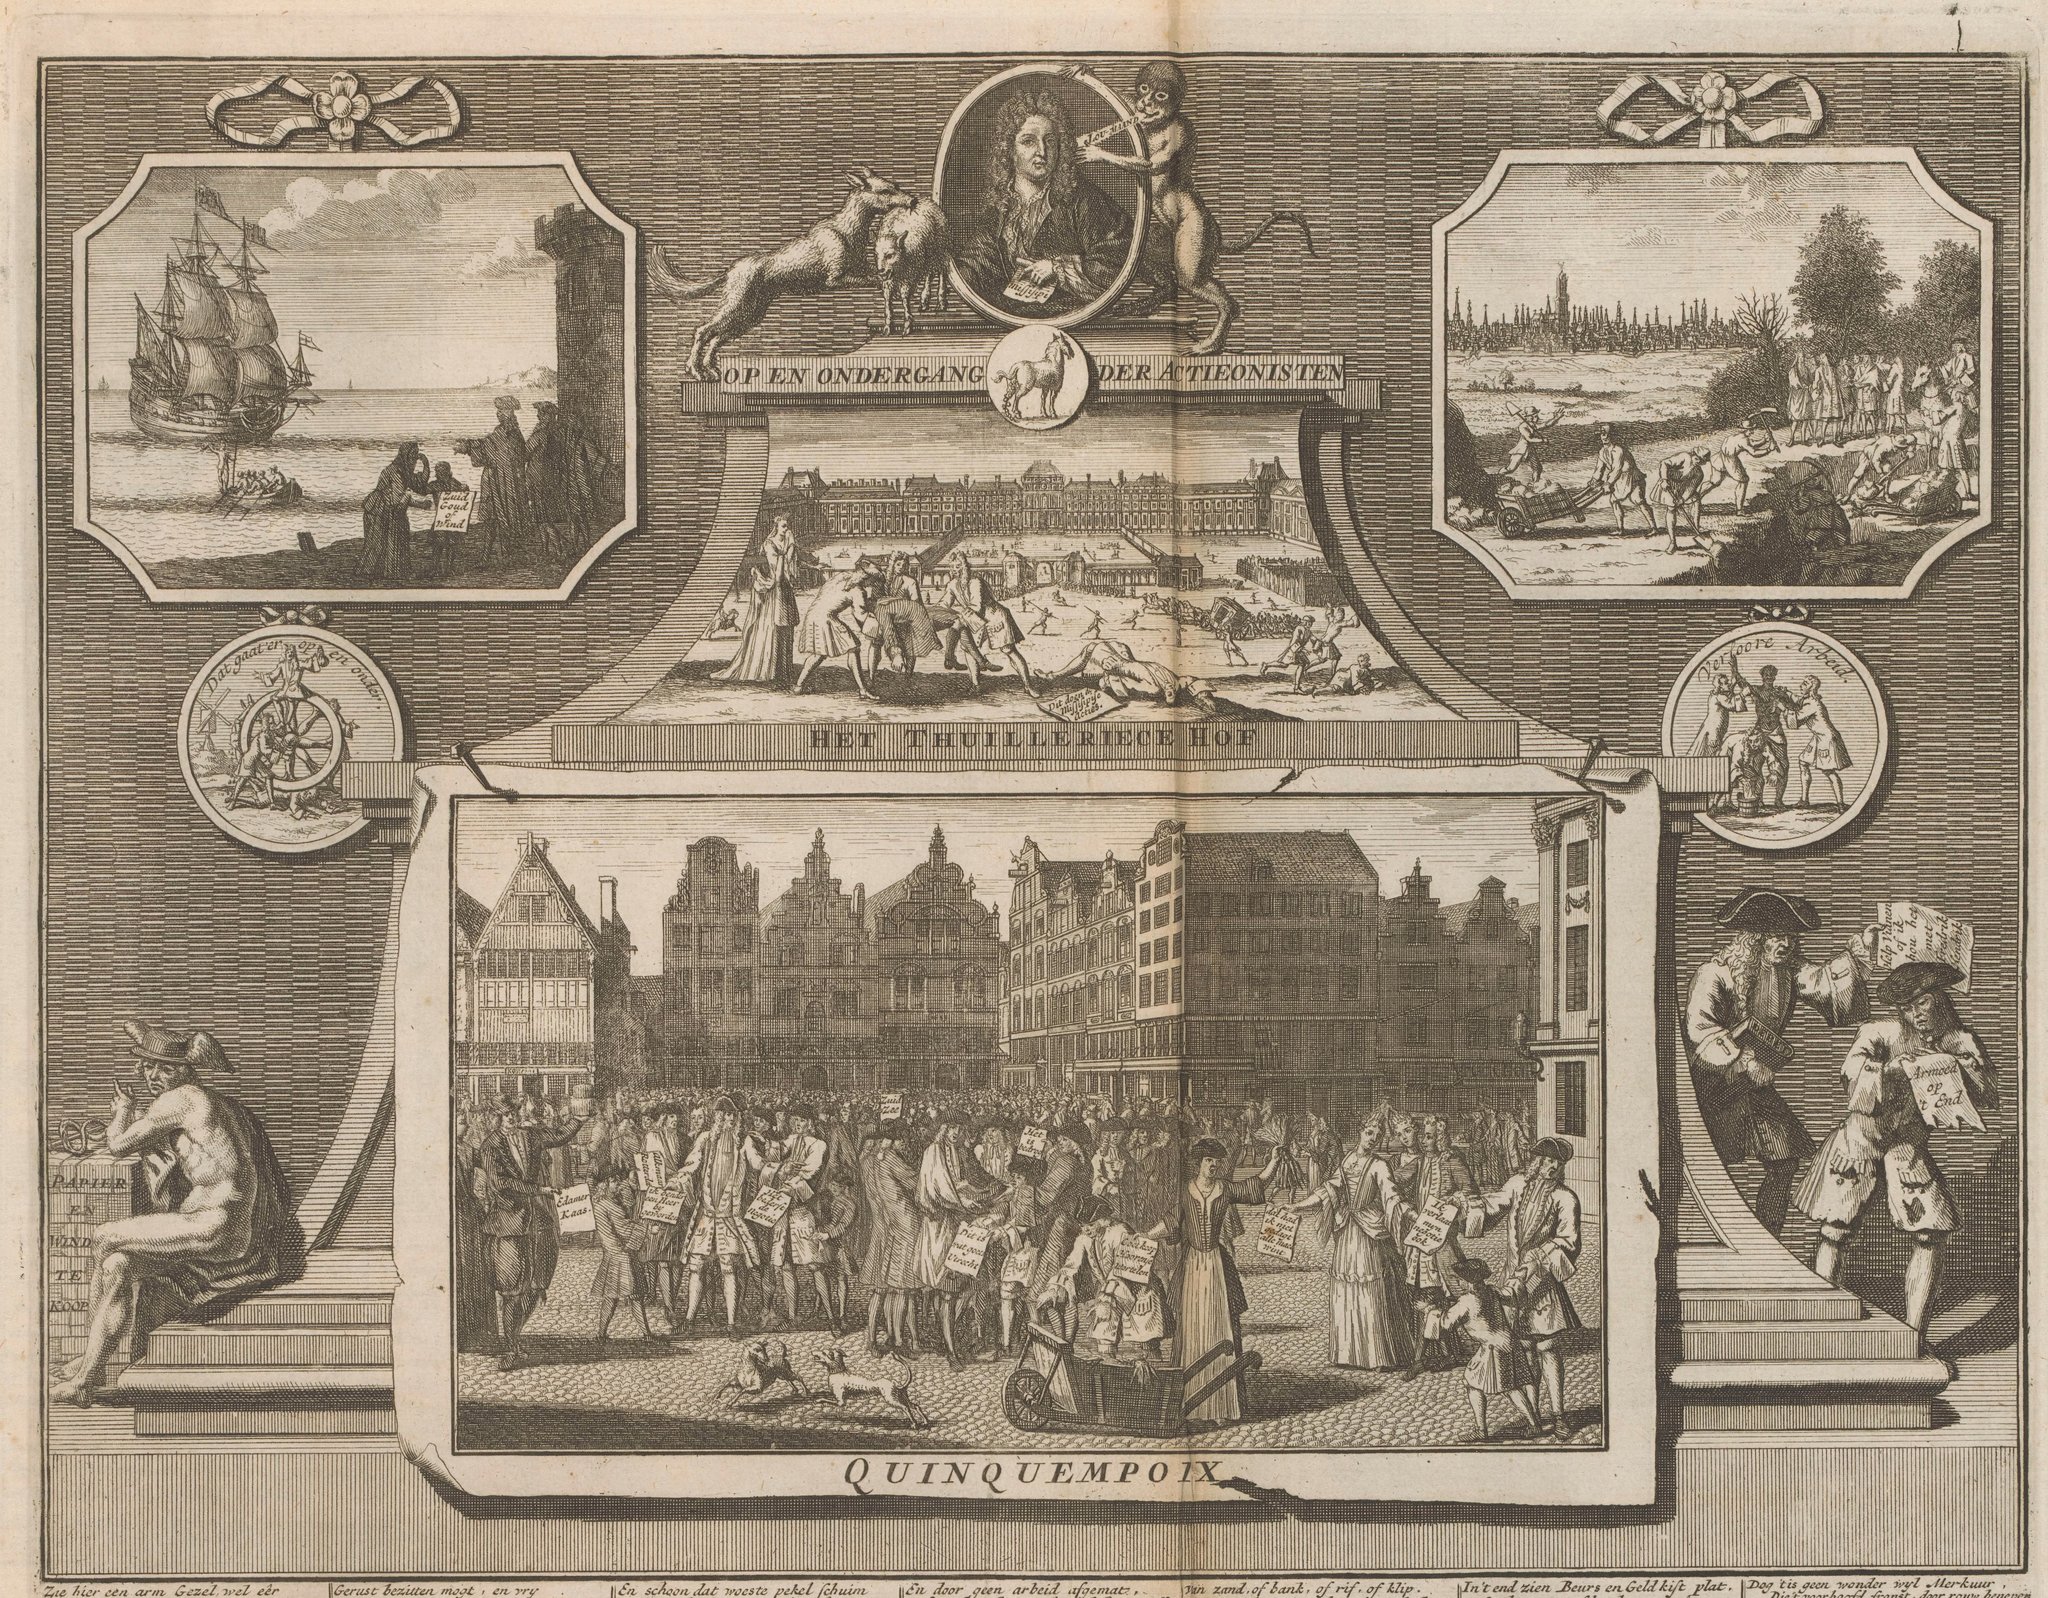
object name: print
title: Op- en Ondergang van de Actionisten, 1720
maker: Anonymous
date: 1720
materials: paper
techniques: etching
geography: northern netherlands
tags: construction of canal, financial panic, utrecht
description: Op- en Ondergang van de Actionisten. Blad met verschillende voorstellingen over de onrust ten gevolge van de Windhandel van 1720. Centraal onderaan Quinquempoix: een menigte slachtoffers van de windhandel verzameld op de Dam bij de Kalverstraat, daarboven Het Thuilleriece Hof: paniek in de Parijse Tuilerieën. Bovenaan een portret van John Law een briefje met Mississippi in de hand, met een aap en een wolf die een schaap bijt. Linksboven koopvaart, rechtsboven graafwerkzaamheden voor het Utrechtse kanaal. In het onderschrift een vers in zeven kolommen. Prent in de gebonden eerste uitgave (304 B 10) van Het Groote Tafereel der Dwaasheid met spotprenten op de Windhandel of Actiehandel van 1720.